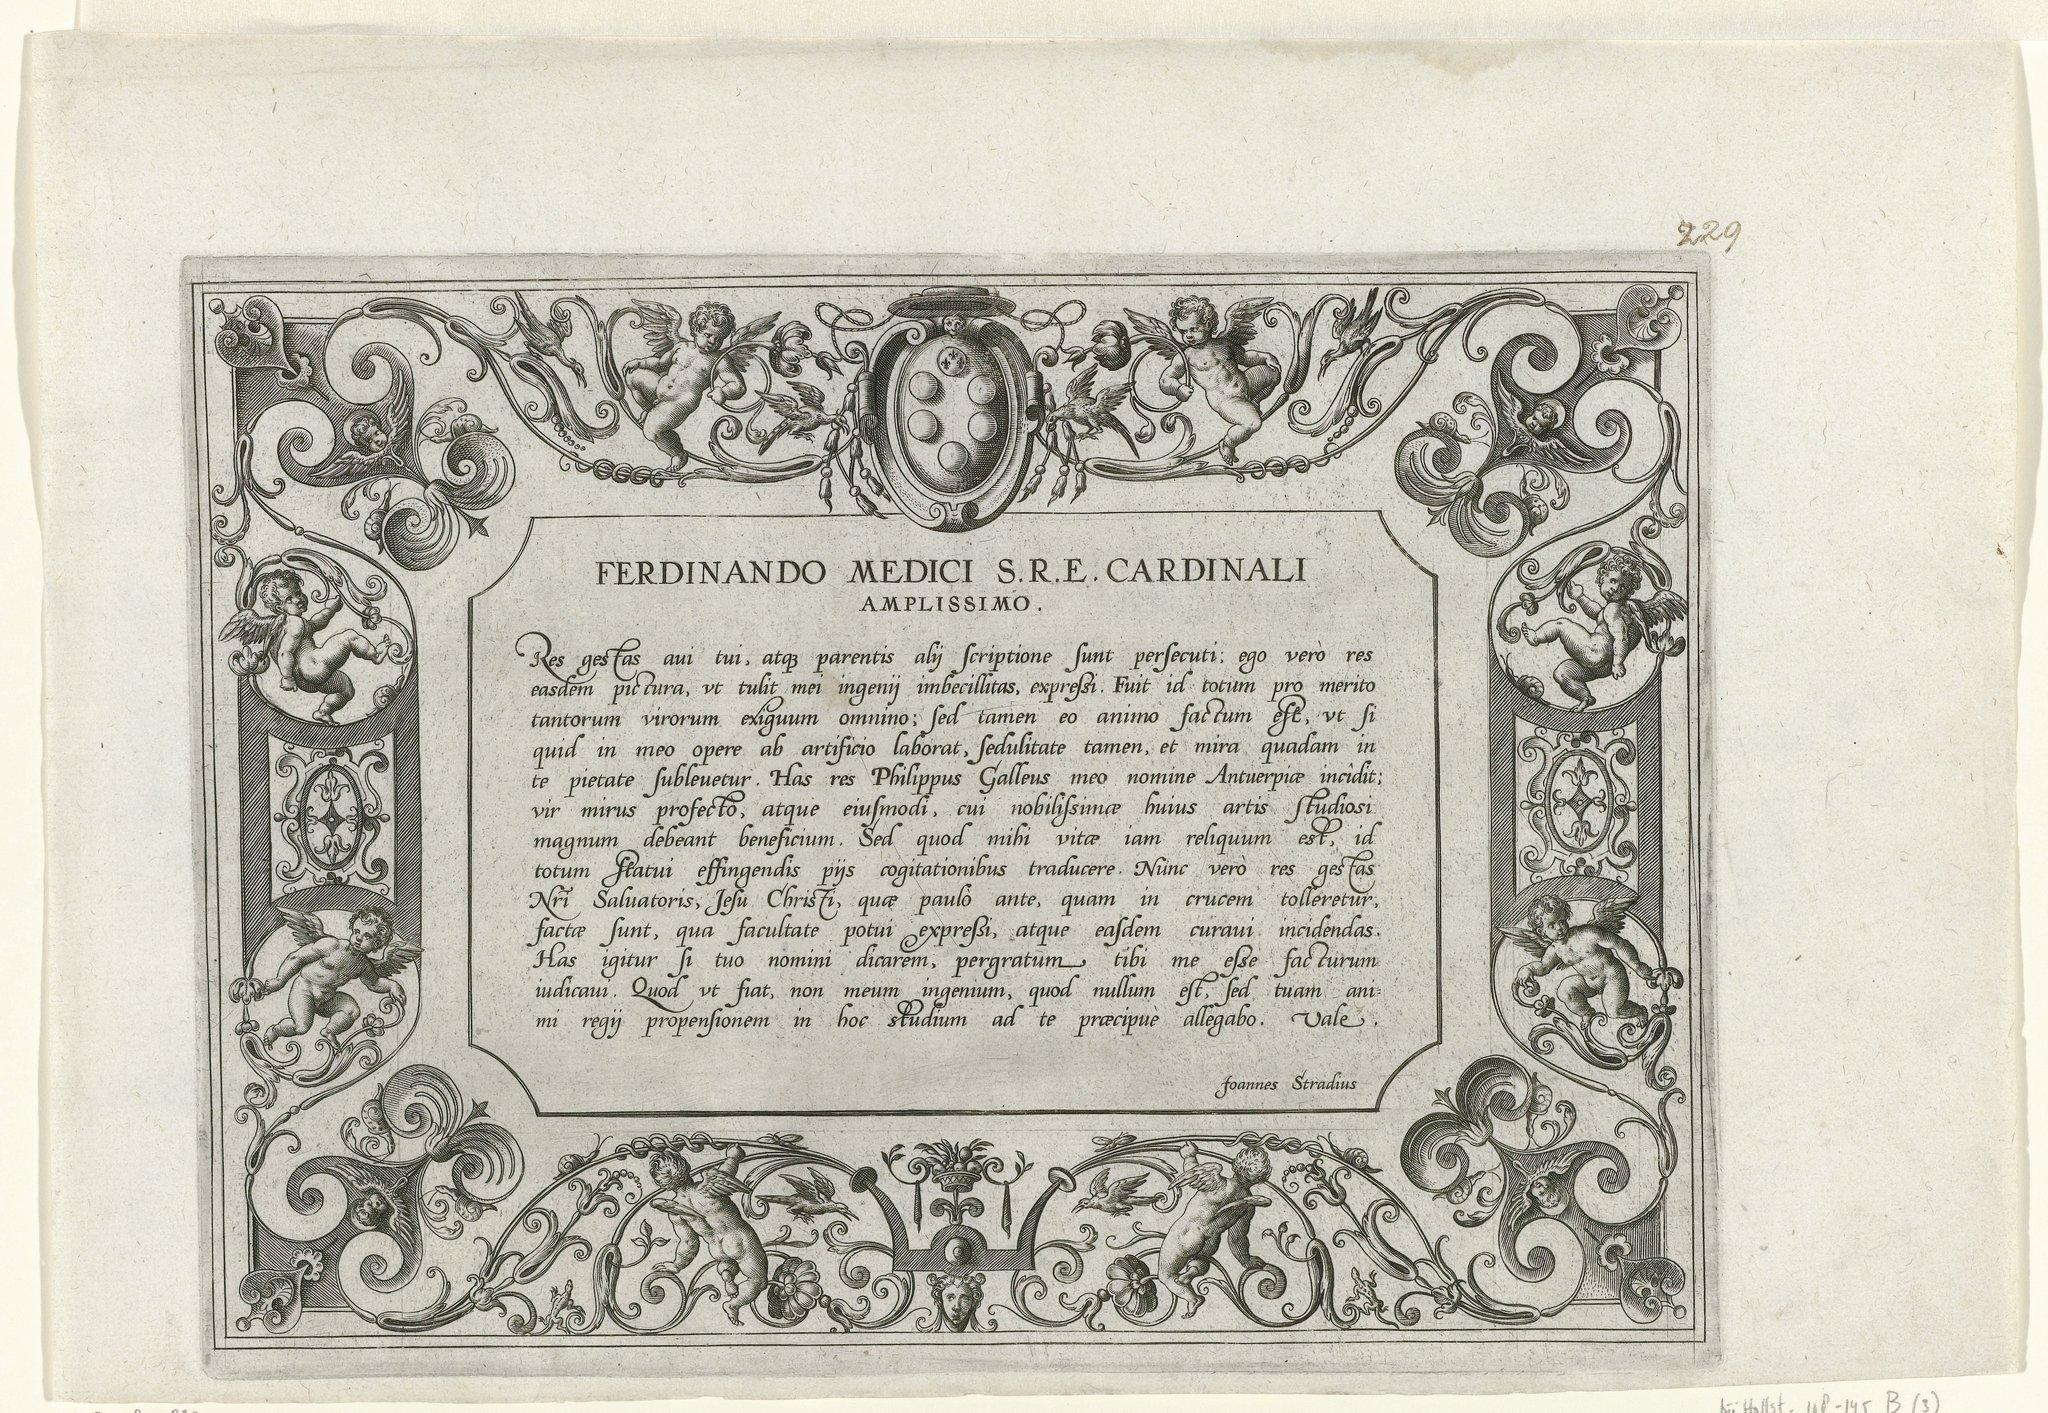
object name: print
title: Passie, dood en wederopstanding van Christus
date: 1585-1586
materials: paper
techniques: engraving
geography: florence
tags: cupids: 'amores', 'amoretti', 'putti', flowers ~ ornament, armorial bearing, heraldry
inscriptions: number: ‘229’, collector's mark: Lugt 2228, watermark: Briquet 309, collector's mark: Lugt 2760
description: In een octagonale lijst een Latijnse dedicatie aan kardinaal Fernando De' Medici. Daarboven het wapenschild van Fernando De' Medici. Rondom de lijst ornamentversiering met putti. De prent maakt deel uit van een serie over het passie, door en wederopstanding van Christus.